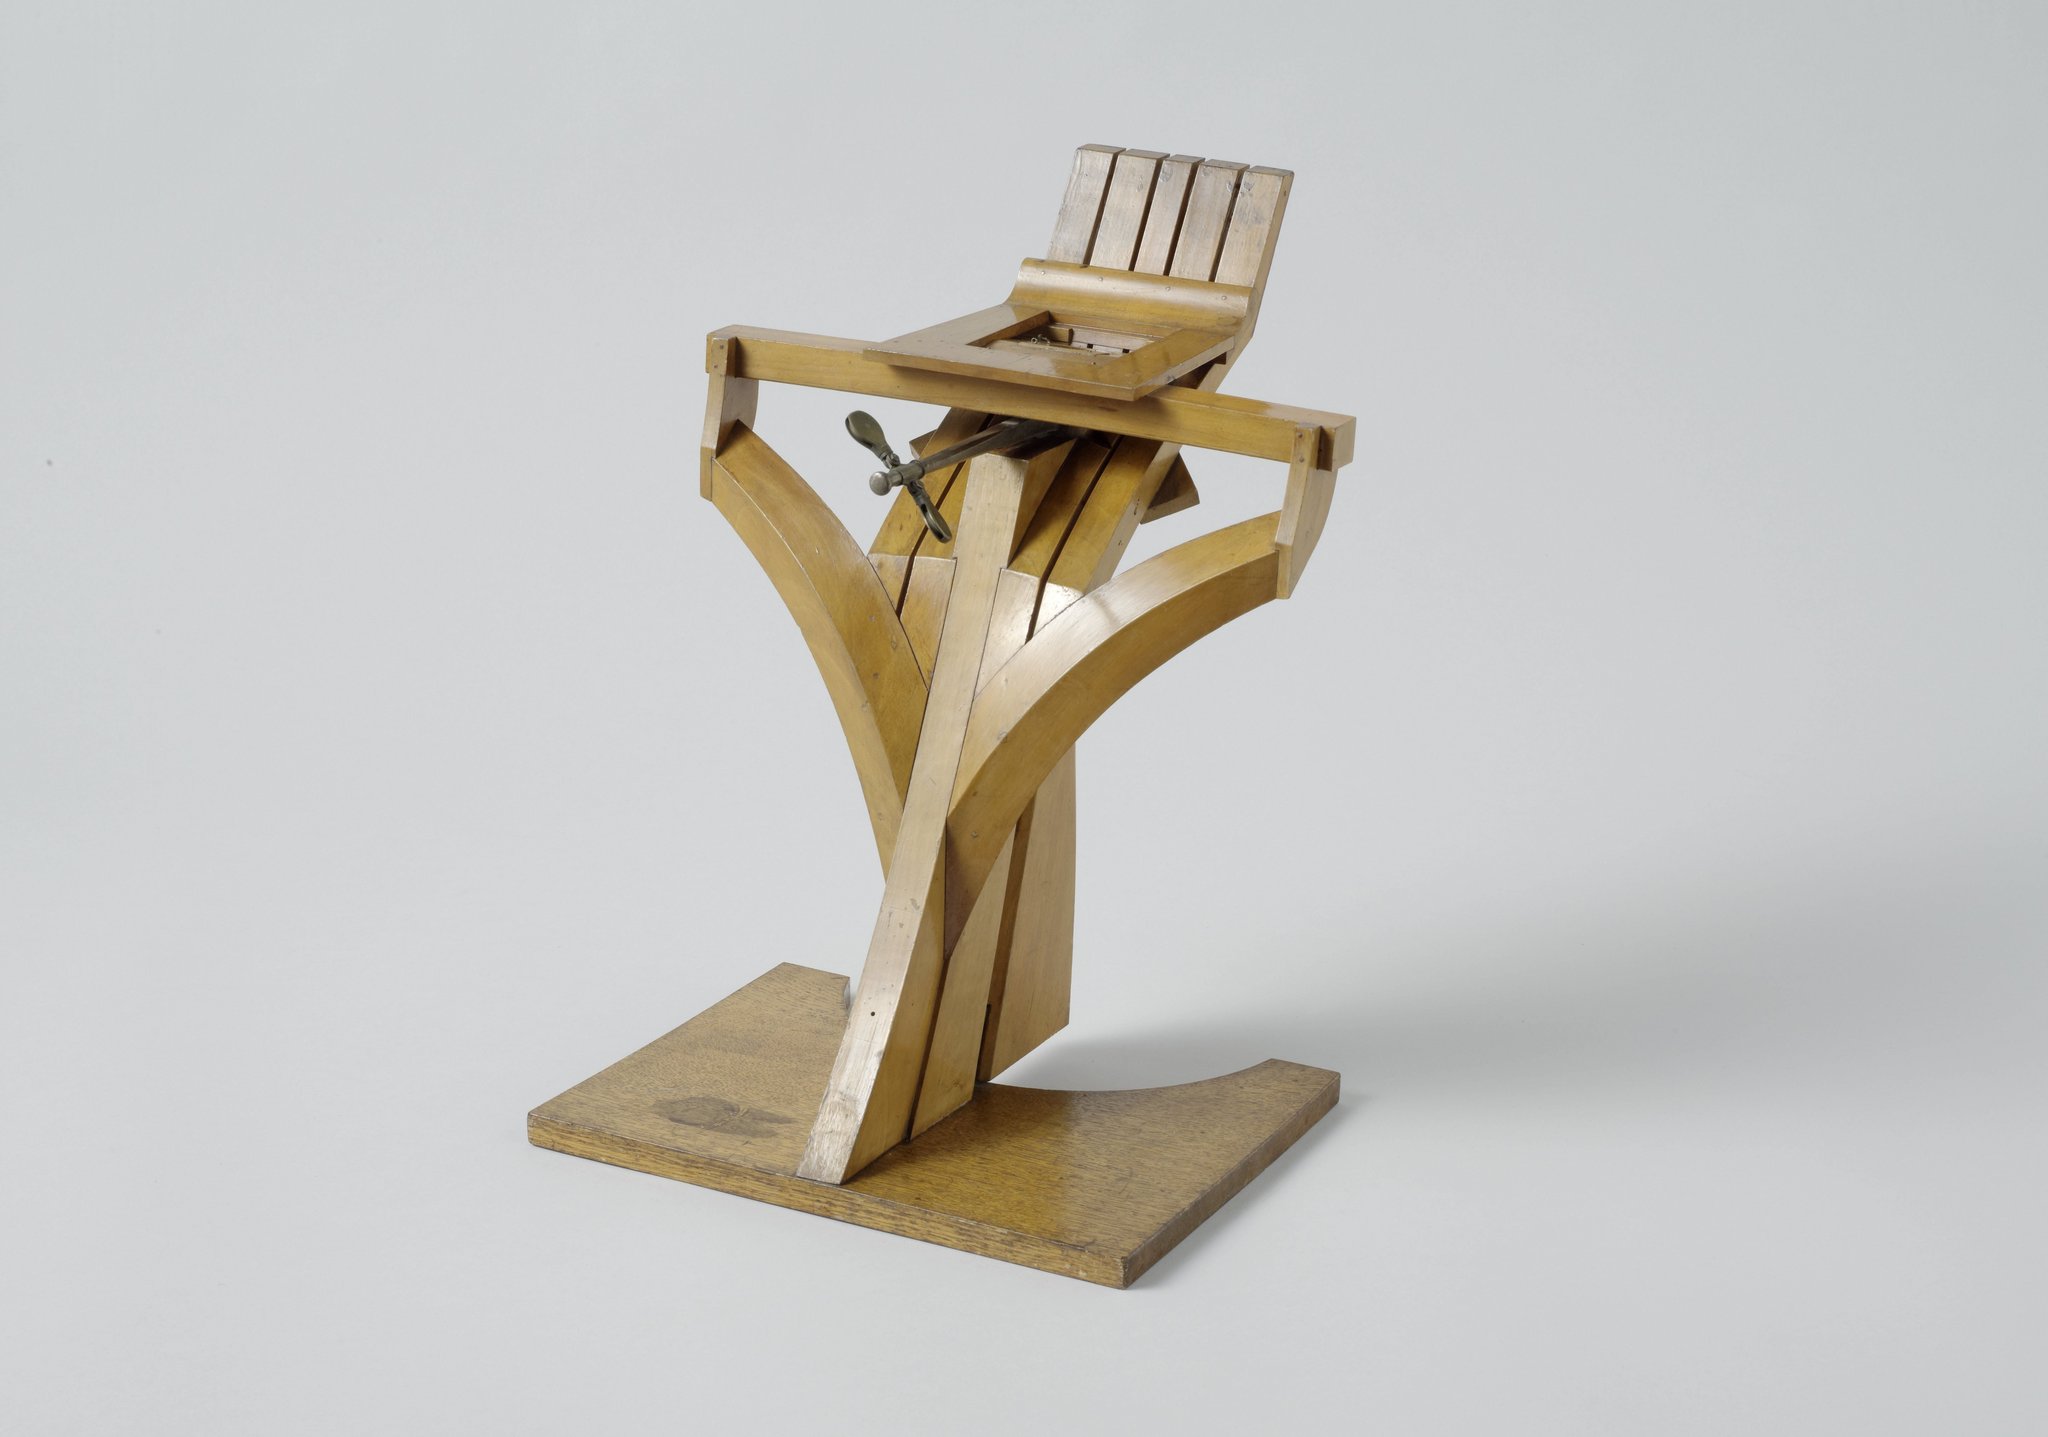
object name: demonstration model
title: Model of a Rudder with a Rapson Slide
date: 1845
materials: brass, iron, wood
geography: flushing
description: Model van het bovenstuk van een roer met ronde roerkoning en delen van een elliptisch hek, op grondplank. De roerkoning is gebogen en heeft een achtkantige top, zodat hij met een borgplaat geblokkeerd kan worden. Twee gaten bovenin de top voor de beugels van een extra roerpen (vgl. NG-MC-1355); de reserve roerpen is teruggevonden, de beugels ontbreken. De ijzeren roerpen, die onderdeks loopt, heeft aan het einde een verschuifbare ijzeren band met twee draaibare blokken: dit is de 'Rapson Slide'.